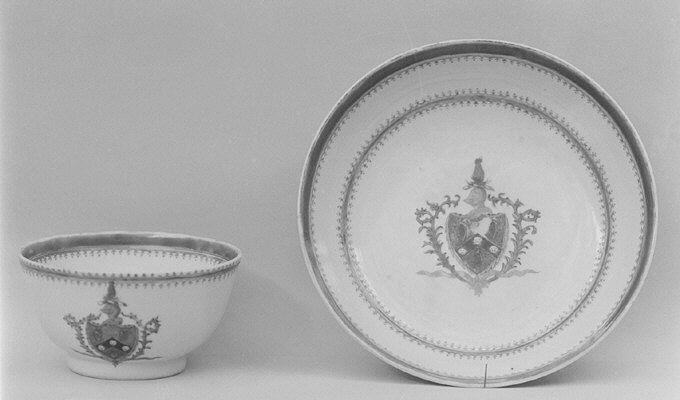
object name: cup and saucer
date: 1776-1800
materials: hard paste porcelain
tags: coat of arms